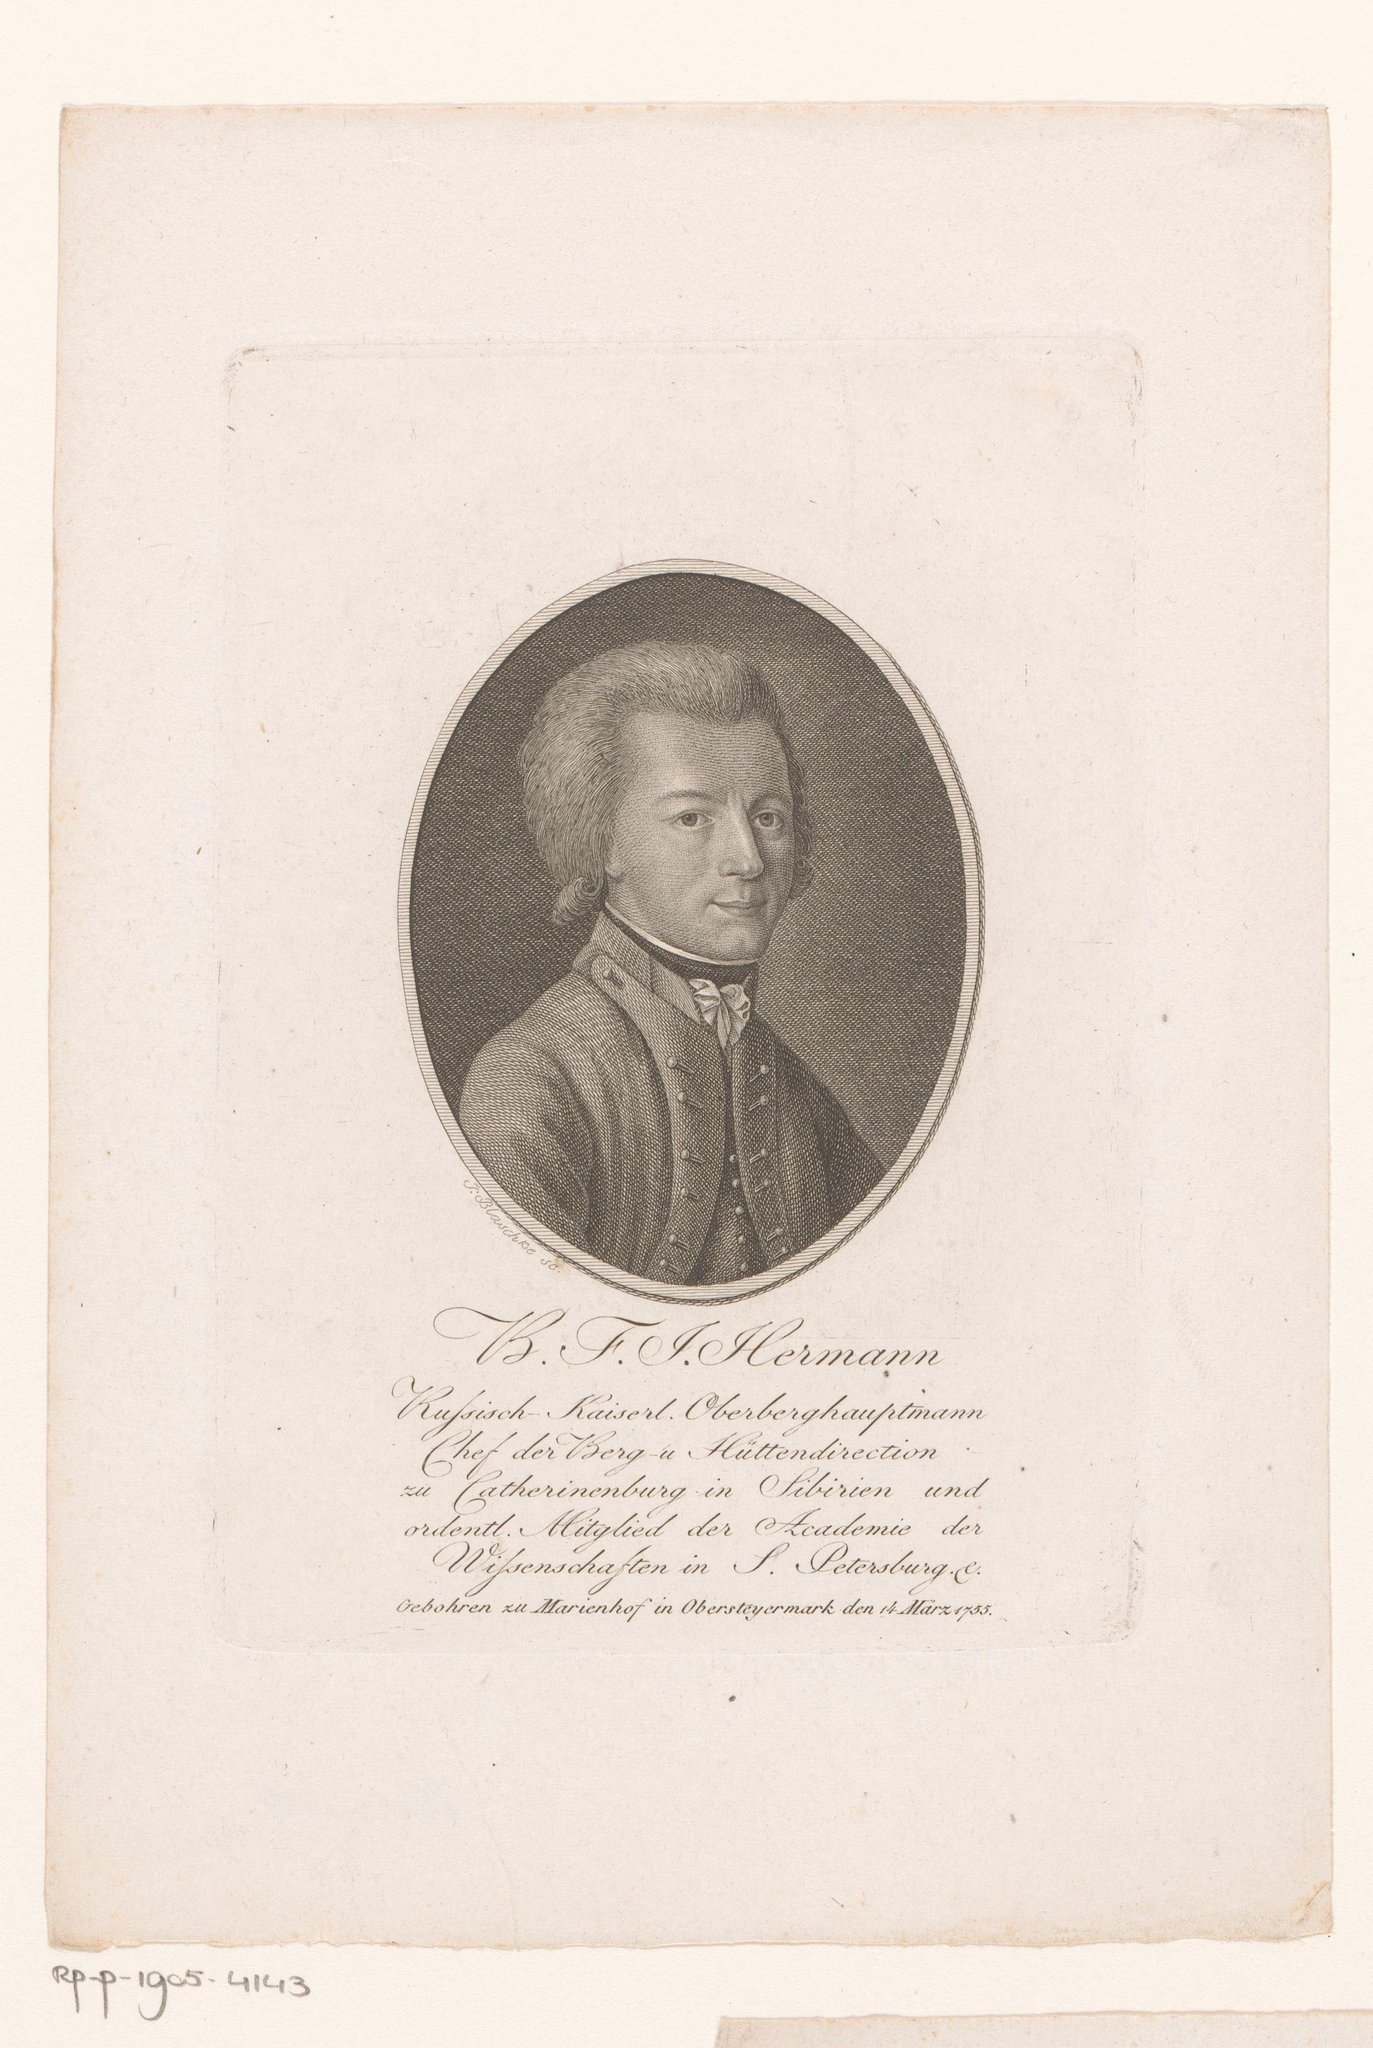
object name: print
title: Portret van Benedikt Franz Johann von Hermann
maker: jános blaschke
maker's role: print maker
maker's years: 1770-1833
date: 1780-1833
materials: paper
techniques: engraving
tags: austria, historical persons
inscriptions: collector's mark: Lugt 2228